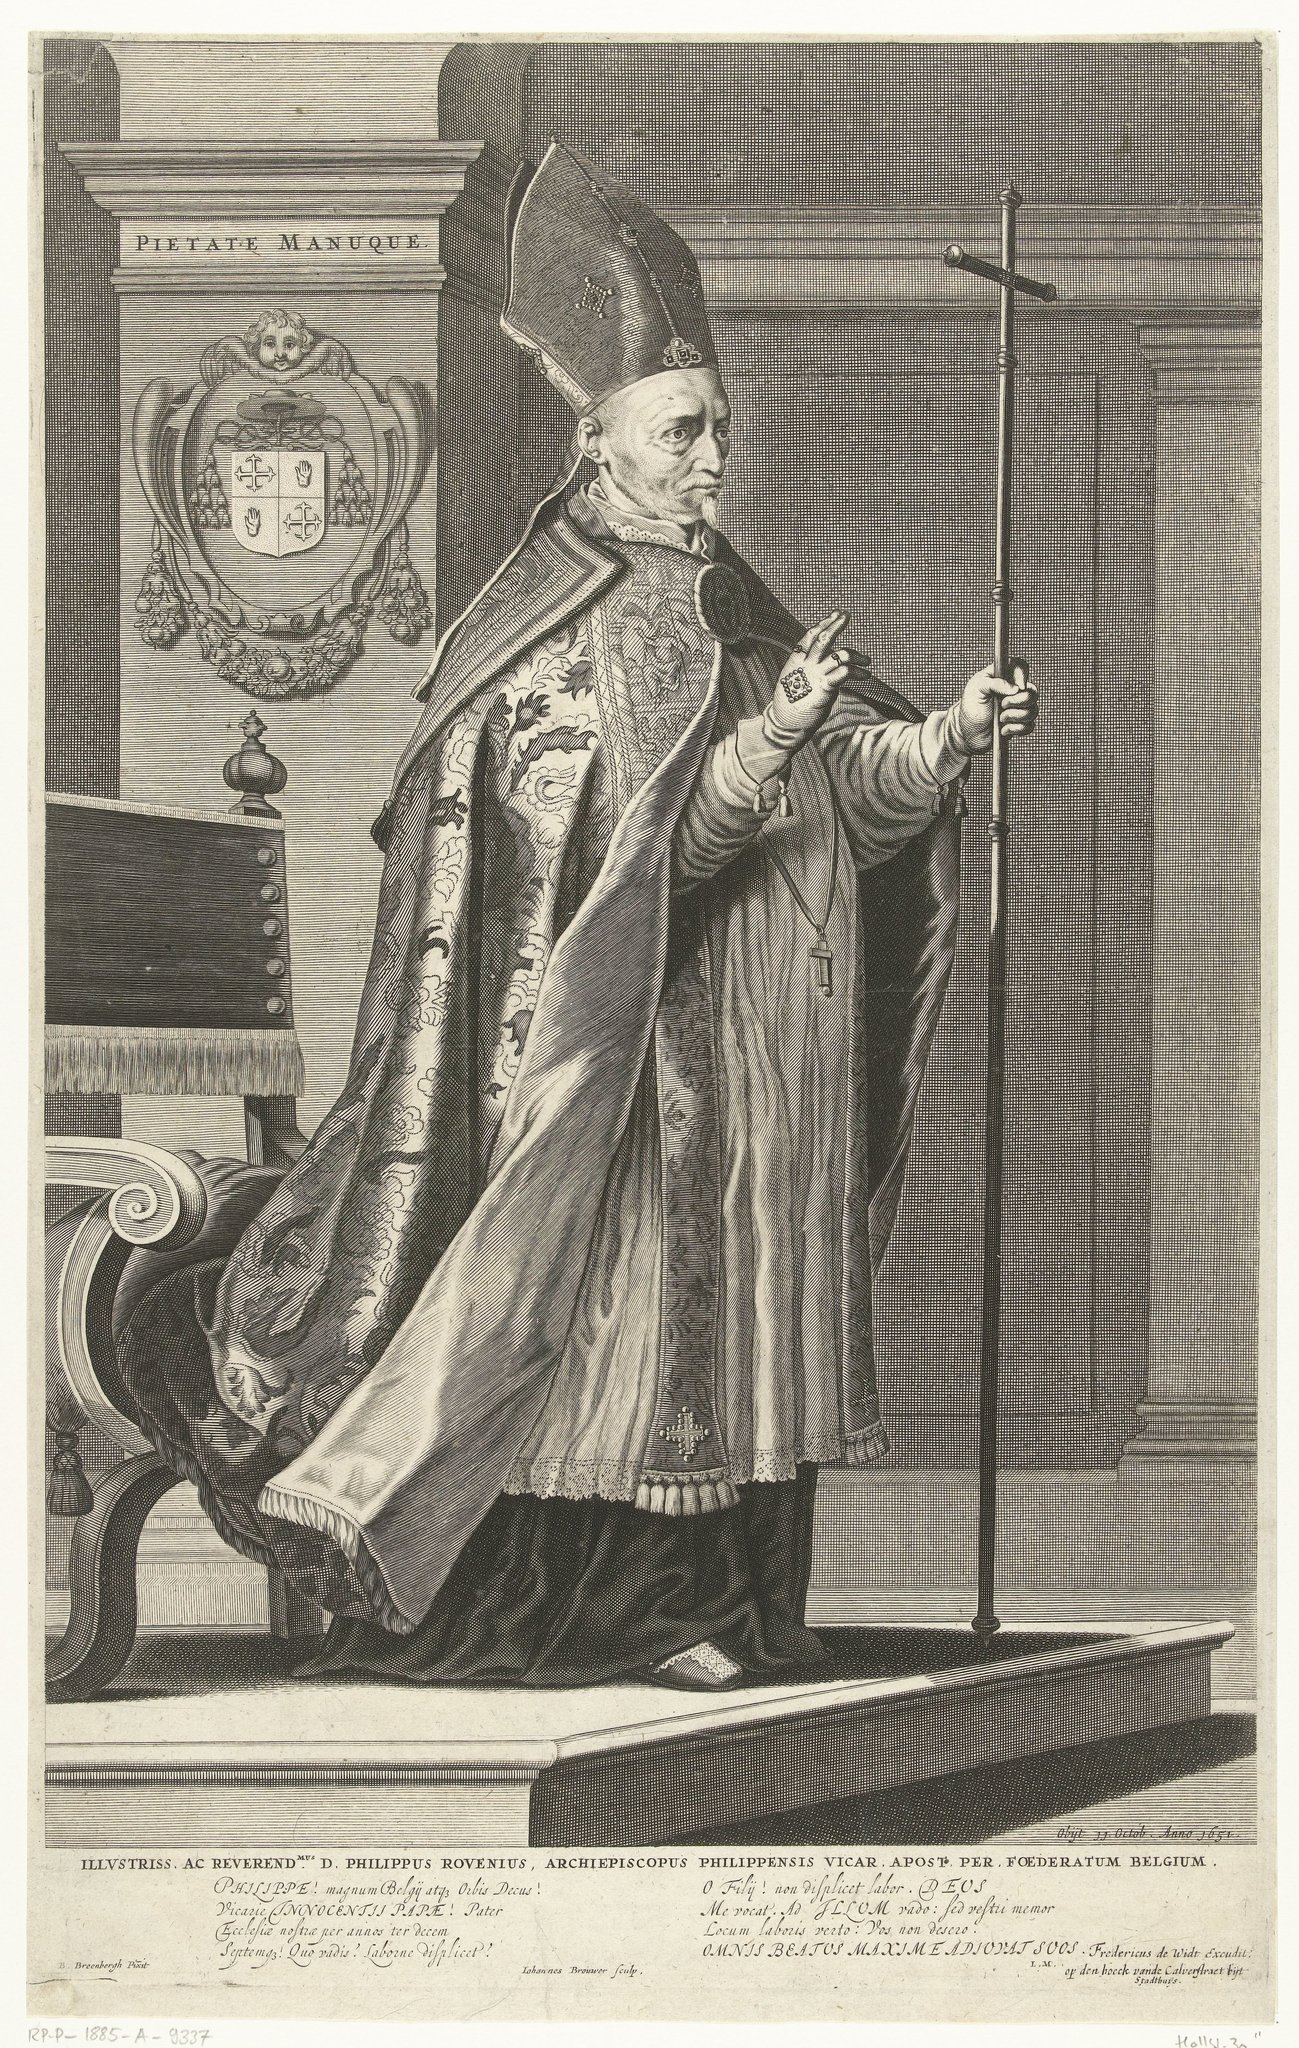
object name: print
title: Philippus Rovenius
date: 1651-1706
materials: paper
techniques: engraving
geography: amsterdam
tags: deventer, utrecht, clergyman, archbishop, bishop, etc. (roman catholic), insignia of bishop, e.g. mitre, crozier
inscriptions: collector's mark: Lugt 2228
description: Portret van de Utrechtse aartsbisschop Filips van Rouveen ten voeten uit. Rouveen houdt een kruis in zijn hand en maakt een zegenend gebaar. Hij draagt de kledij van een bisschop. Op de muur op een pilaar zijn motto: 'Pietate manuque'.